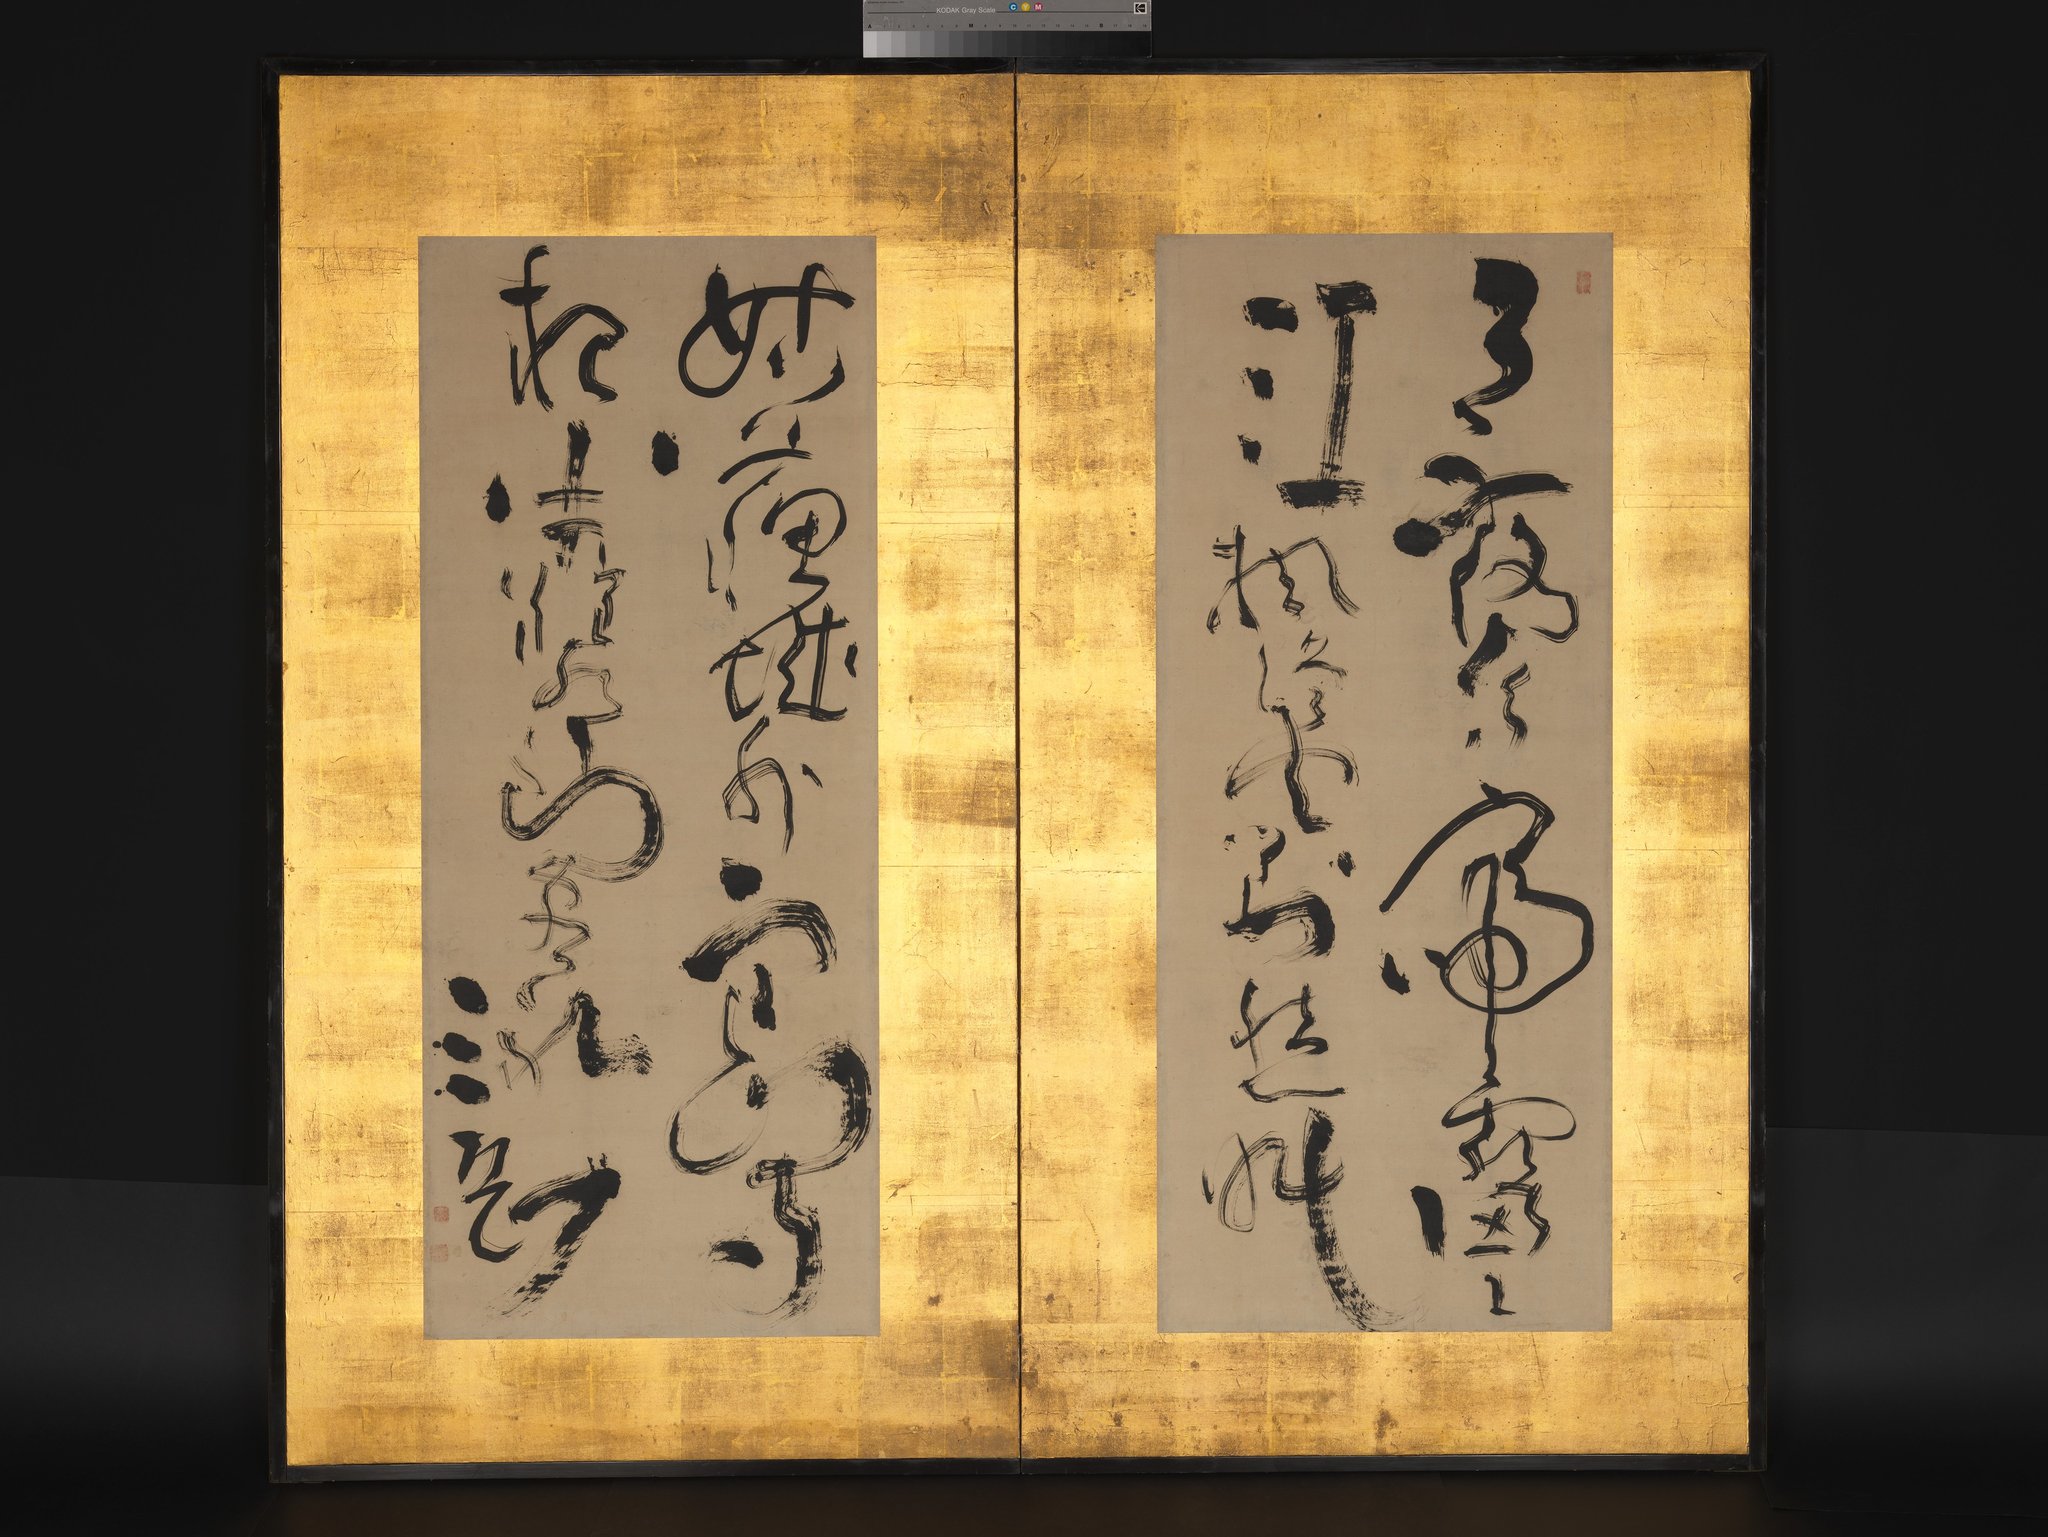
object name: screen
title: "Maple Bridge Night Mooring"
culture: japanese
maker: ike no taiga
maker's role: artist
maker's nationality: japanese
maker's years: 1723-1776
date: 1770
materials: ink, panel, paper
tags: poetry,calligraphy